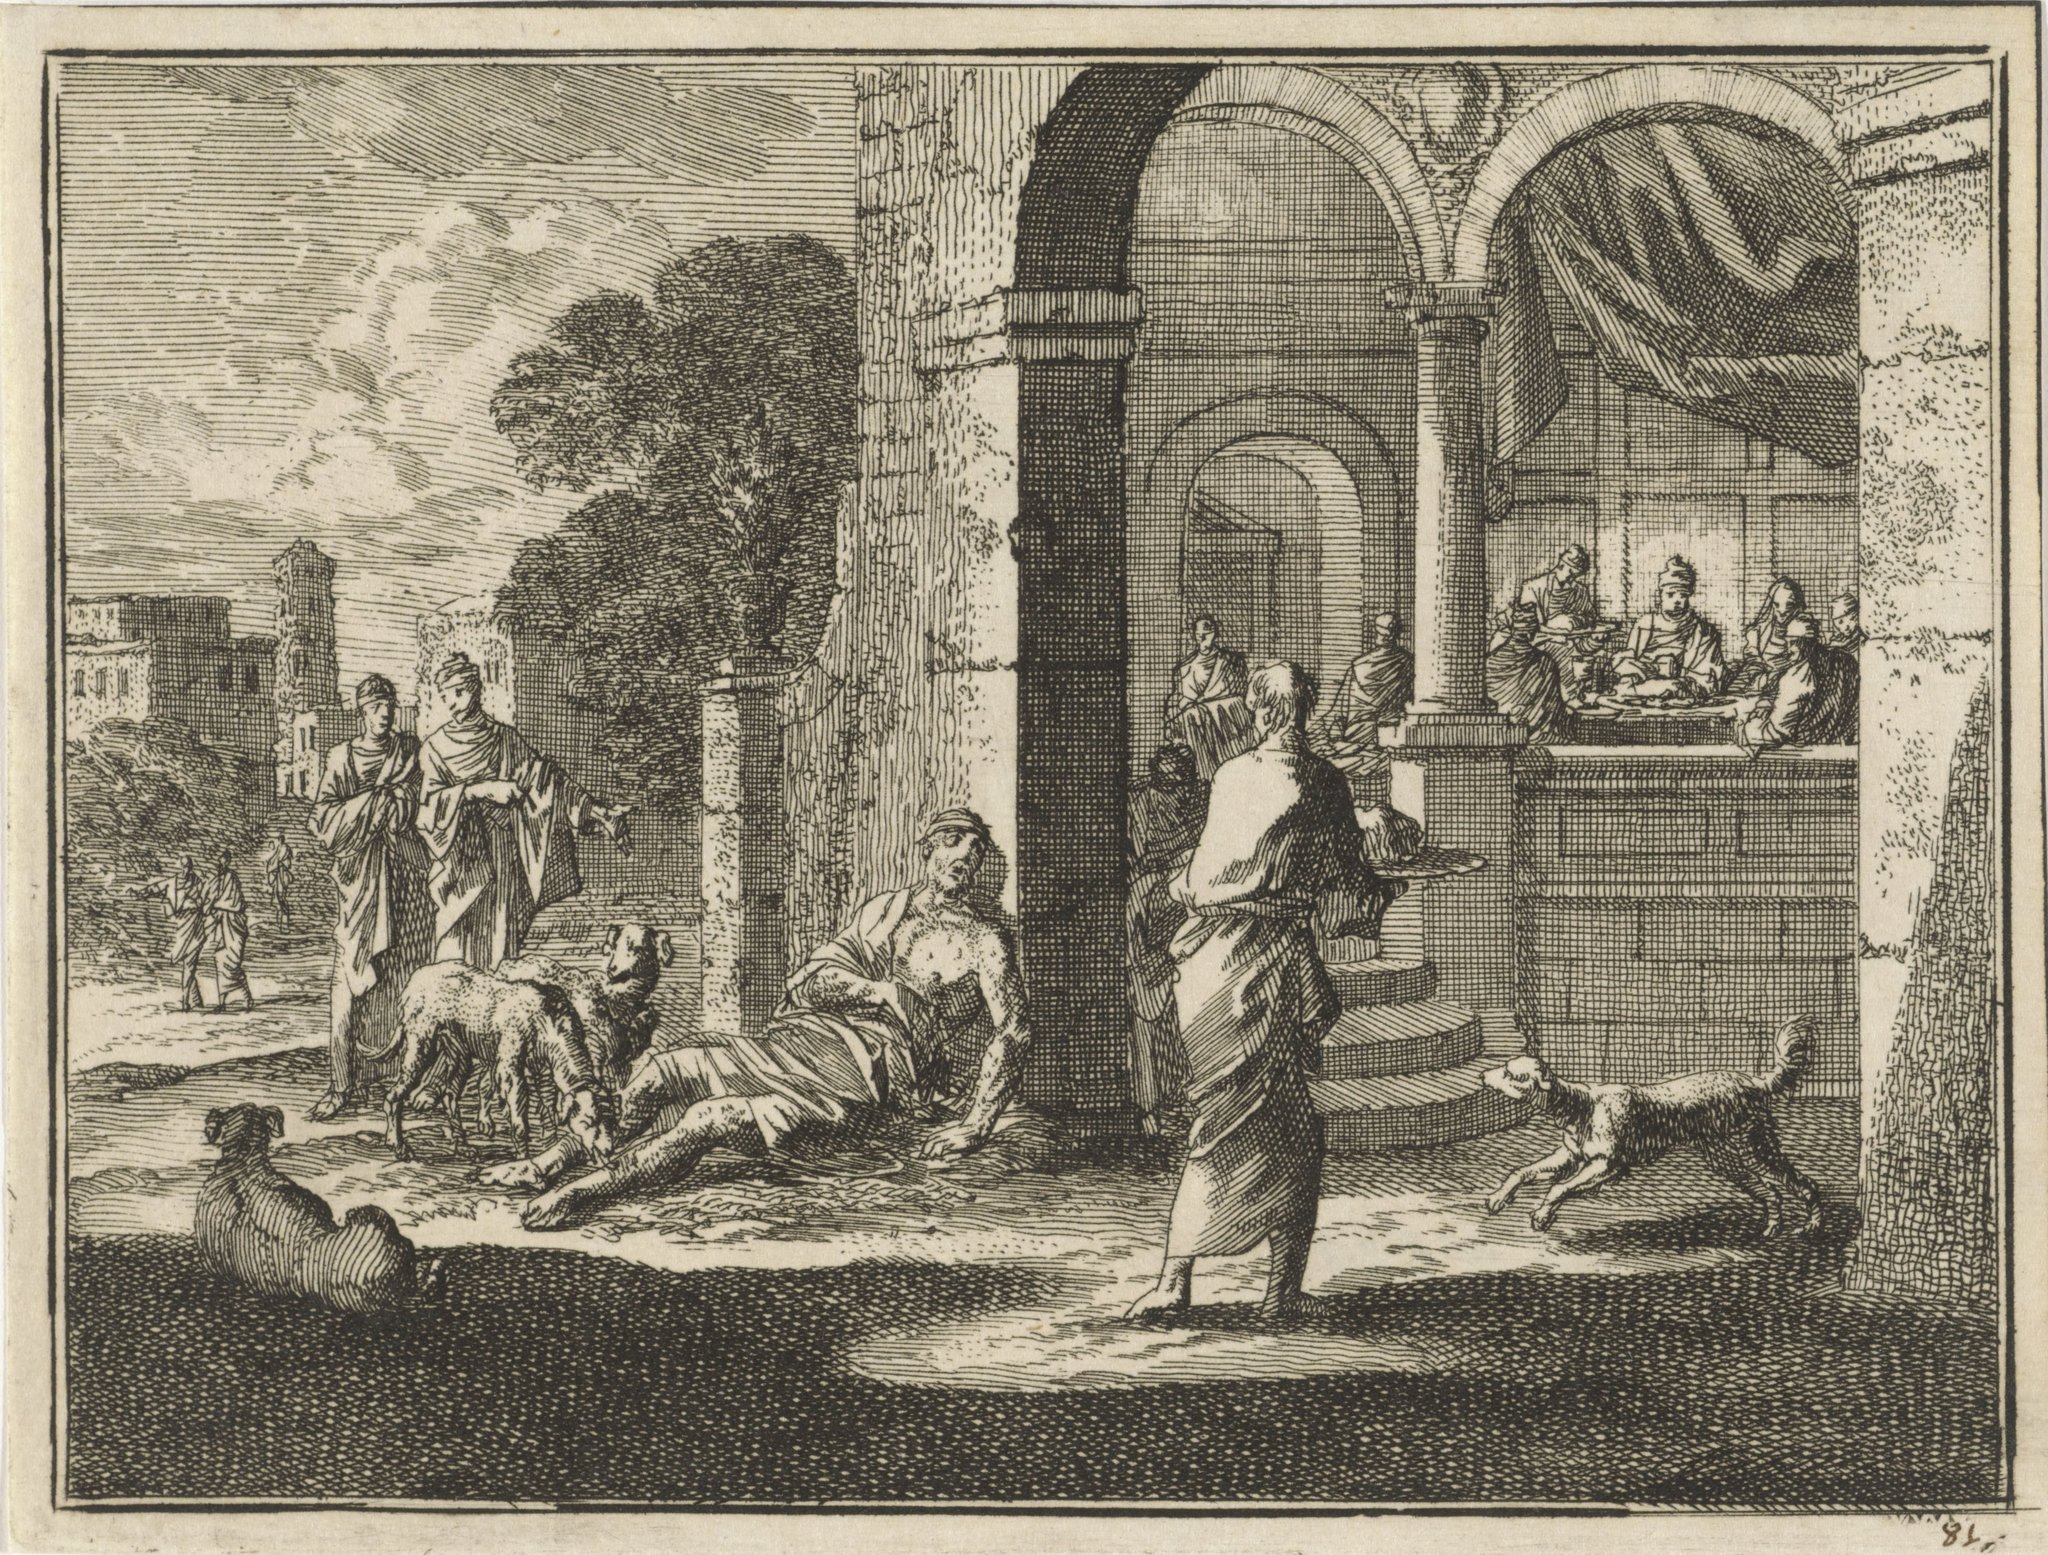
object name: print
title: De rijke man en de arme Lazarus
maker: jan luyken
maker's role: draughtsman, print maker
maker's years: 1649-1712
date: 1712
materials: paper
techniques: etching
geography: amsterdam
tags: the rich man (dives) is feasting, while poor lazarus is starving at the gate (dogs licking lazarus' sores) (luke 16:19-31)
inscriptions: number: ‘81’, collector's mark: Lugt 2228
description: Proefdruk van illustratie uit: Luyken, Jan. De schriftuurlyke geschiedenissen en gelykenissen van het Oude en Nieuwe Verbond, 2 delen. Amsterdam: Wed. Pieter Arentsz II en Cornelis van der Sys, 1712, dl. II.